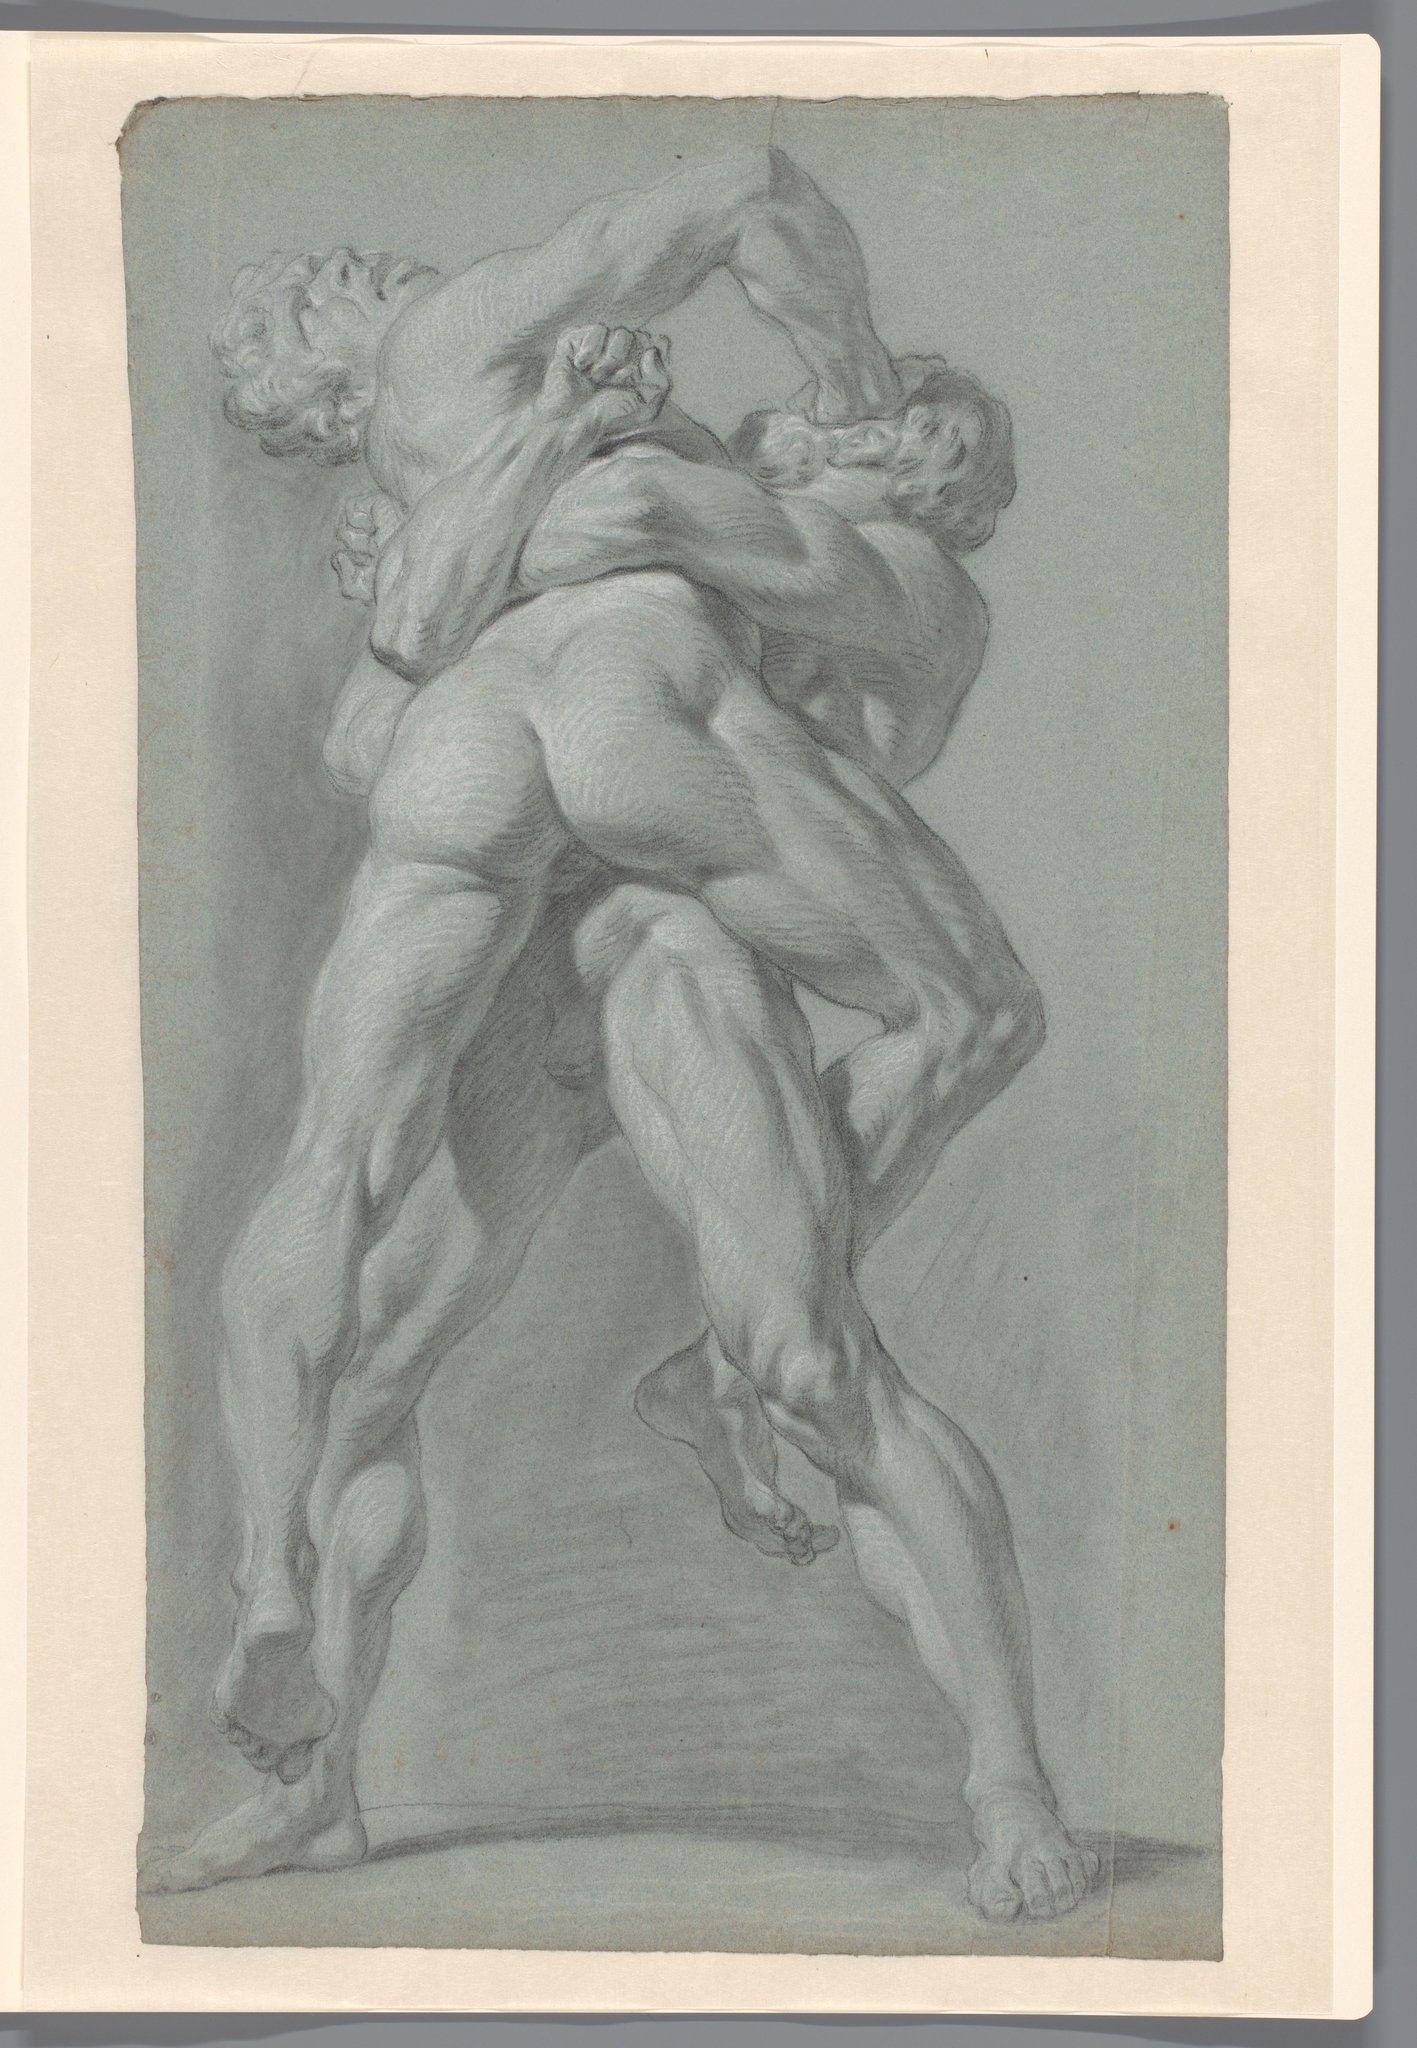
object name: drawing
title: Kopie naar een beeldengroep van Hercules en Antaeus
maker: cornelis joseph d heur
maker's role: draughtsman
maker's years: 1707-1762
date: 1717-1762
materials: chalk, paper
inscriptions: collector's mark: Lugt 2228